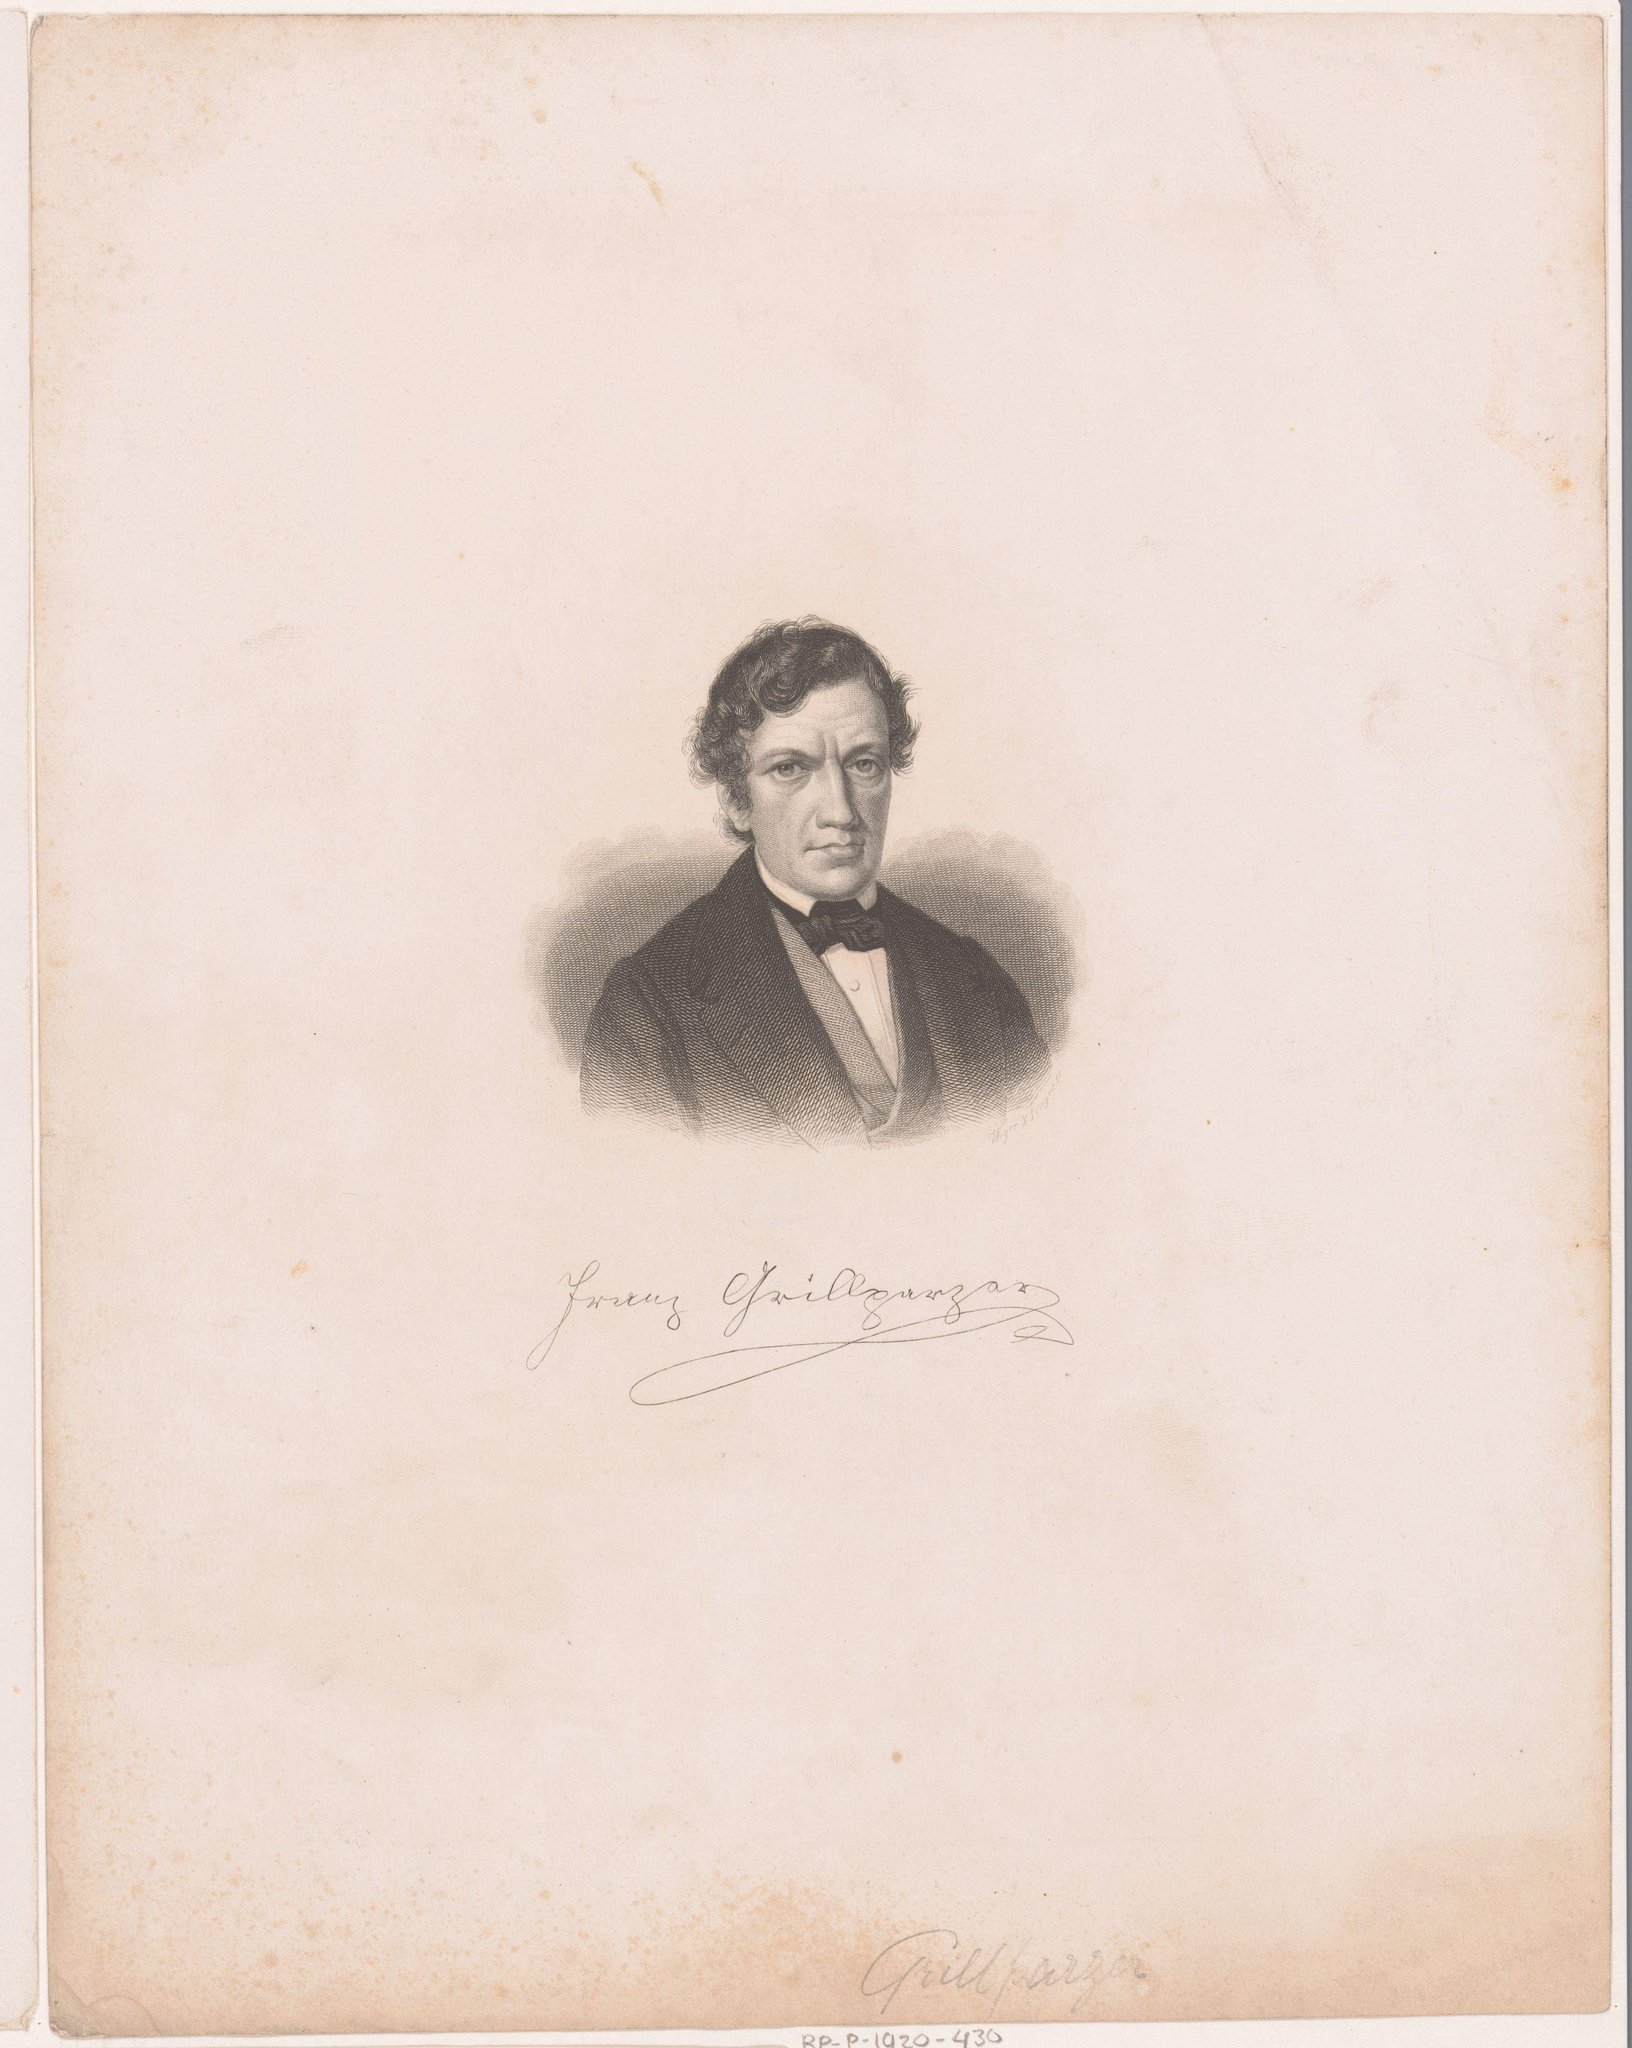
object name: print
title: Portret van Franz Grillparzer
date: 1849-1892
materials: paper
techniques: engraving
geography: leipzig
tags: vienna, historical persons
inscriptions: collector's mark: Lugt 2228